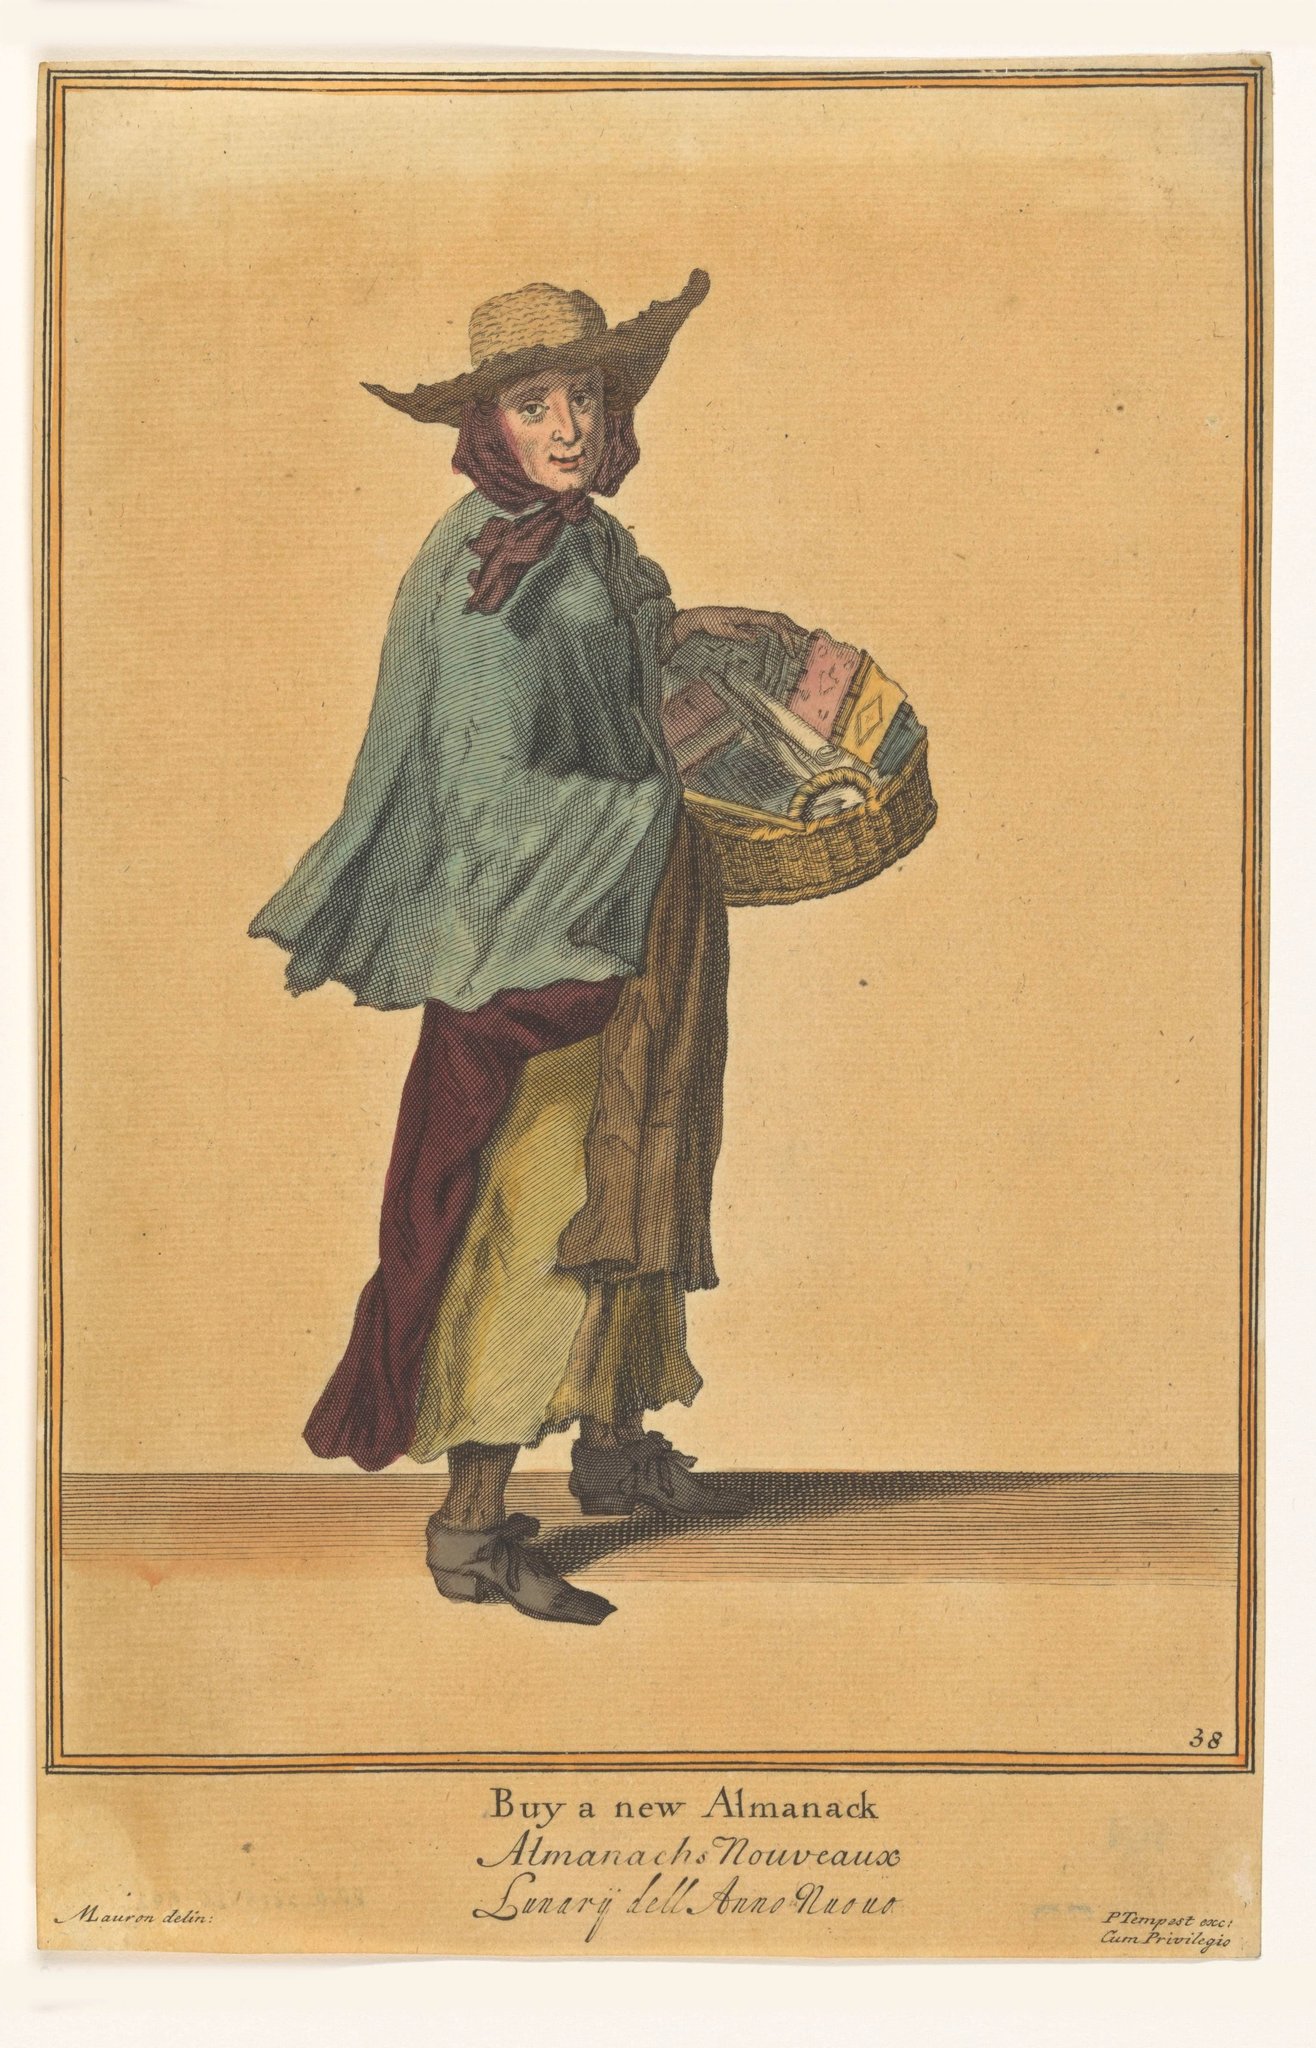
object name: print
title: Verkoopster van almanakken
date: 1688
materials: paper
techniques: engraving, etching, hand coloring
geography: london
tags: street-trader, book-shop, bookseller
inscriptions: collector's mark: Lugt 4779, collector's mark: Lugt 2228, collector's mark: Lugt 4780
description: Voor het eerst gepubliceerd in 1688. Waarschijnlijk is deze prent afkomstig uit een latere editie, mogelijk uitgegeven door Henry Overton I.